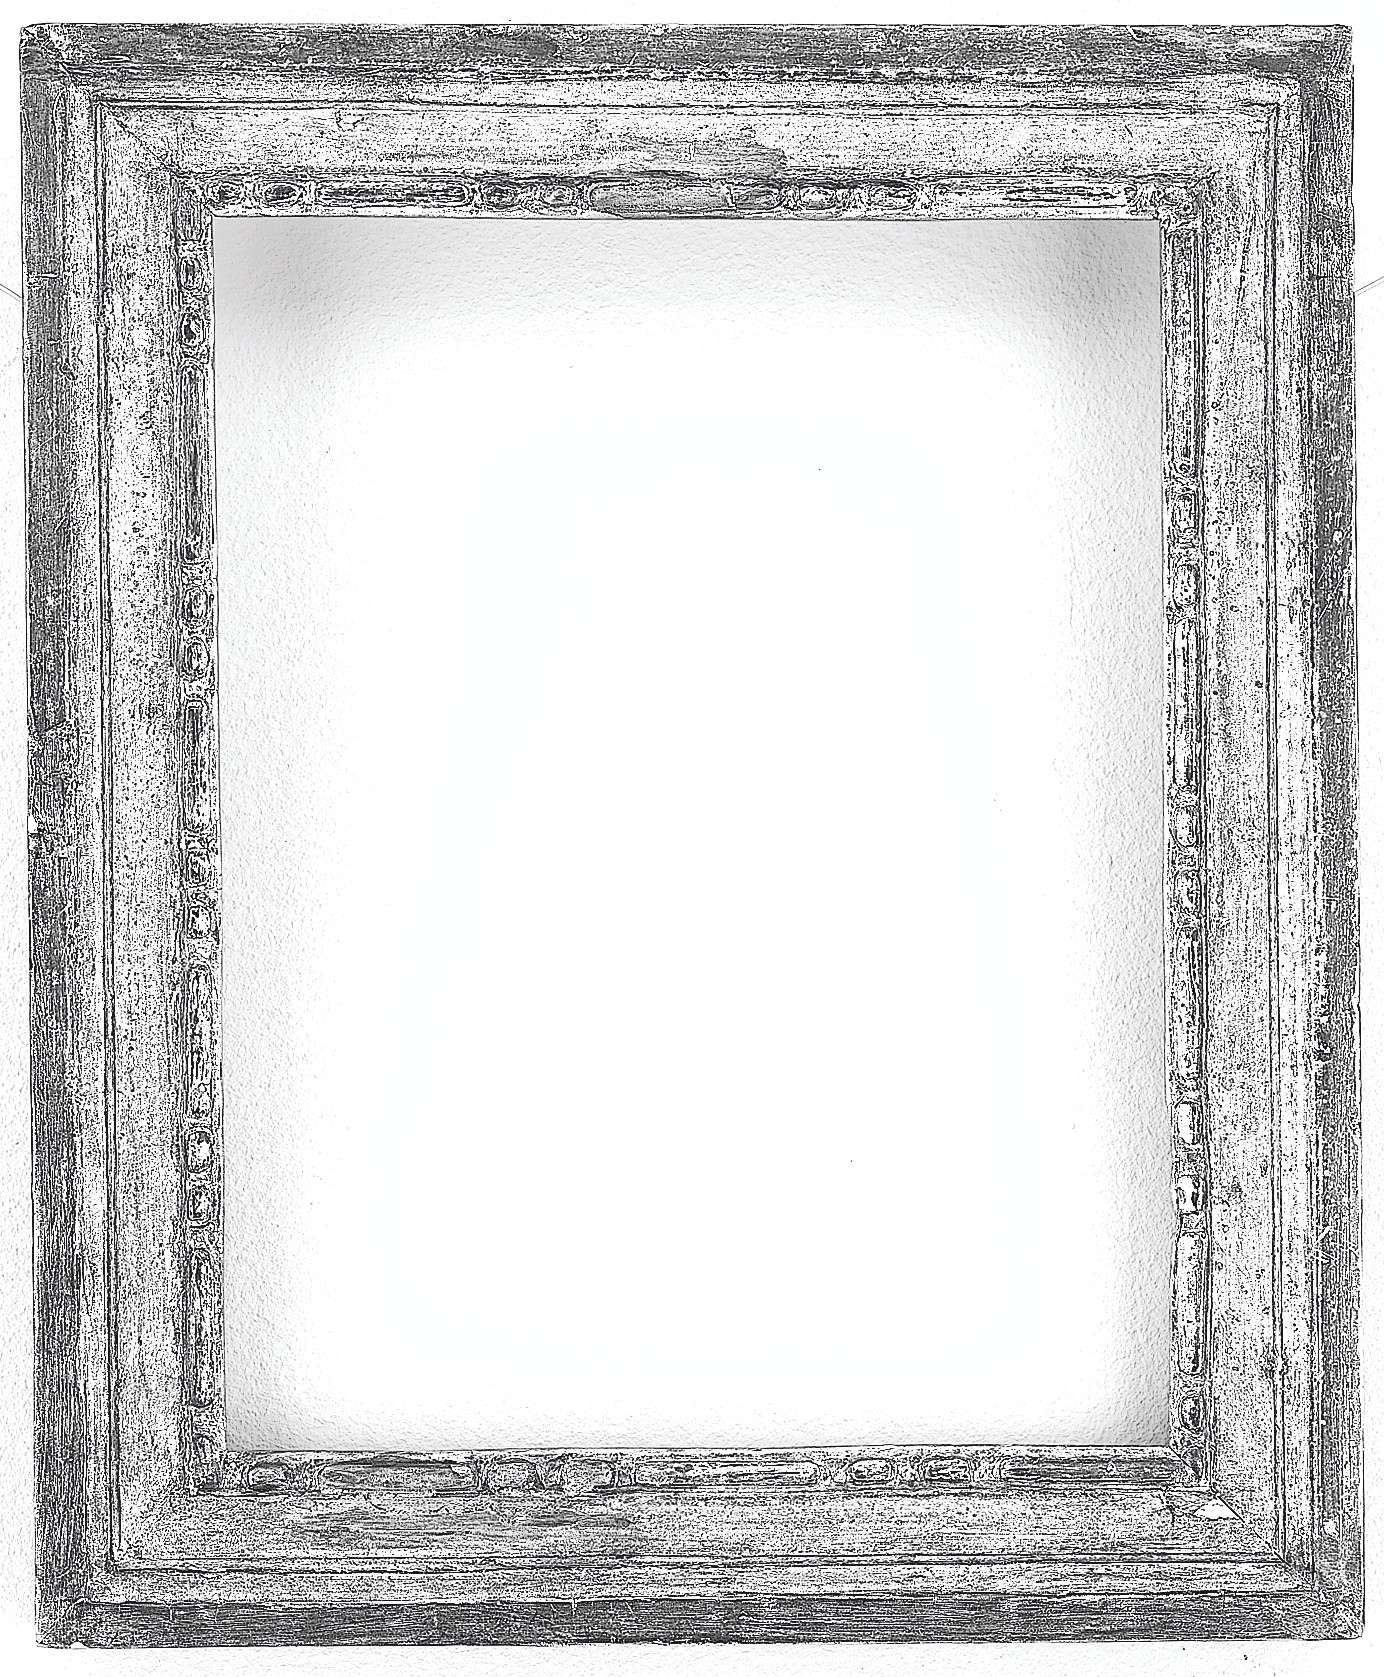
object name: frame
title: Cassetta frame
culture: german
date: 1800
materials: wood